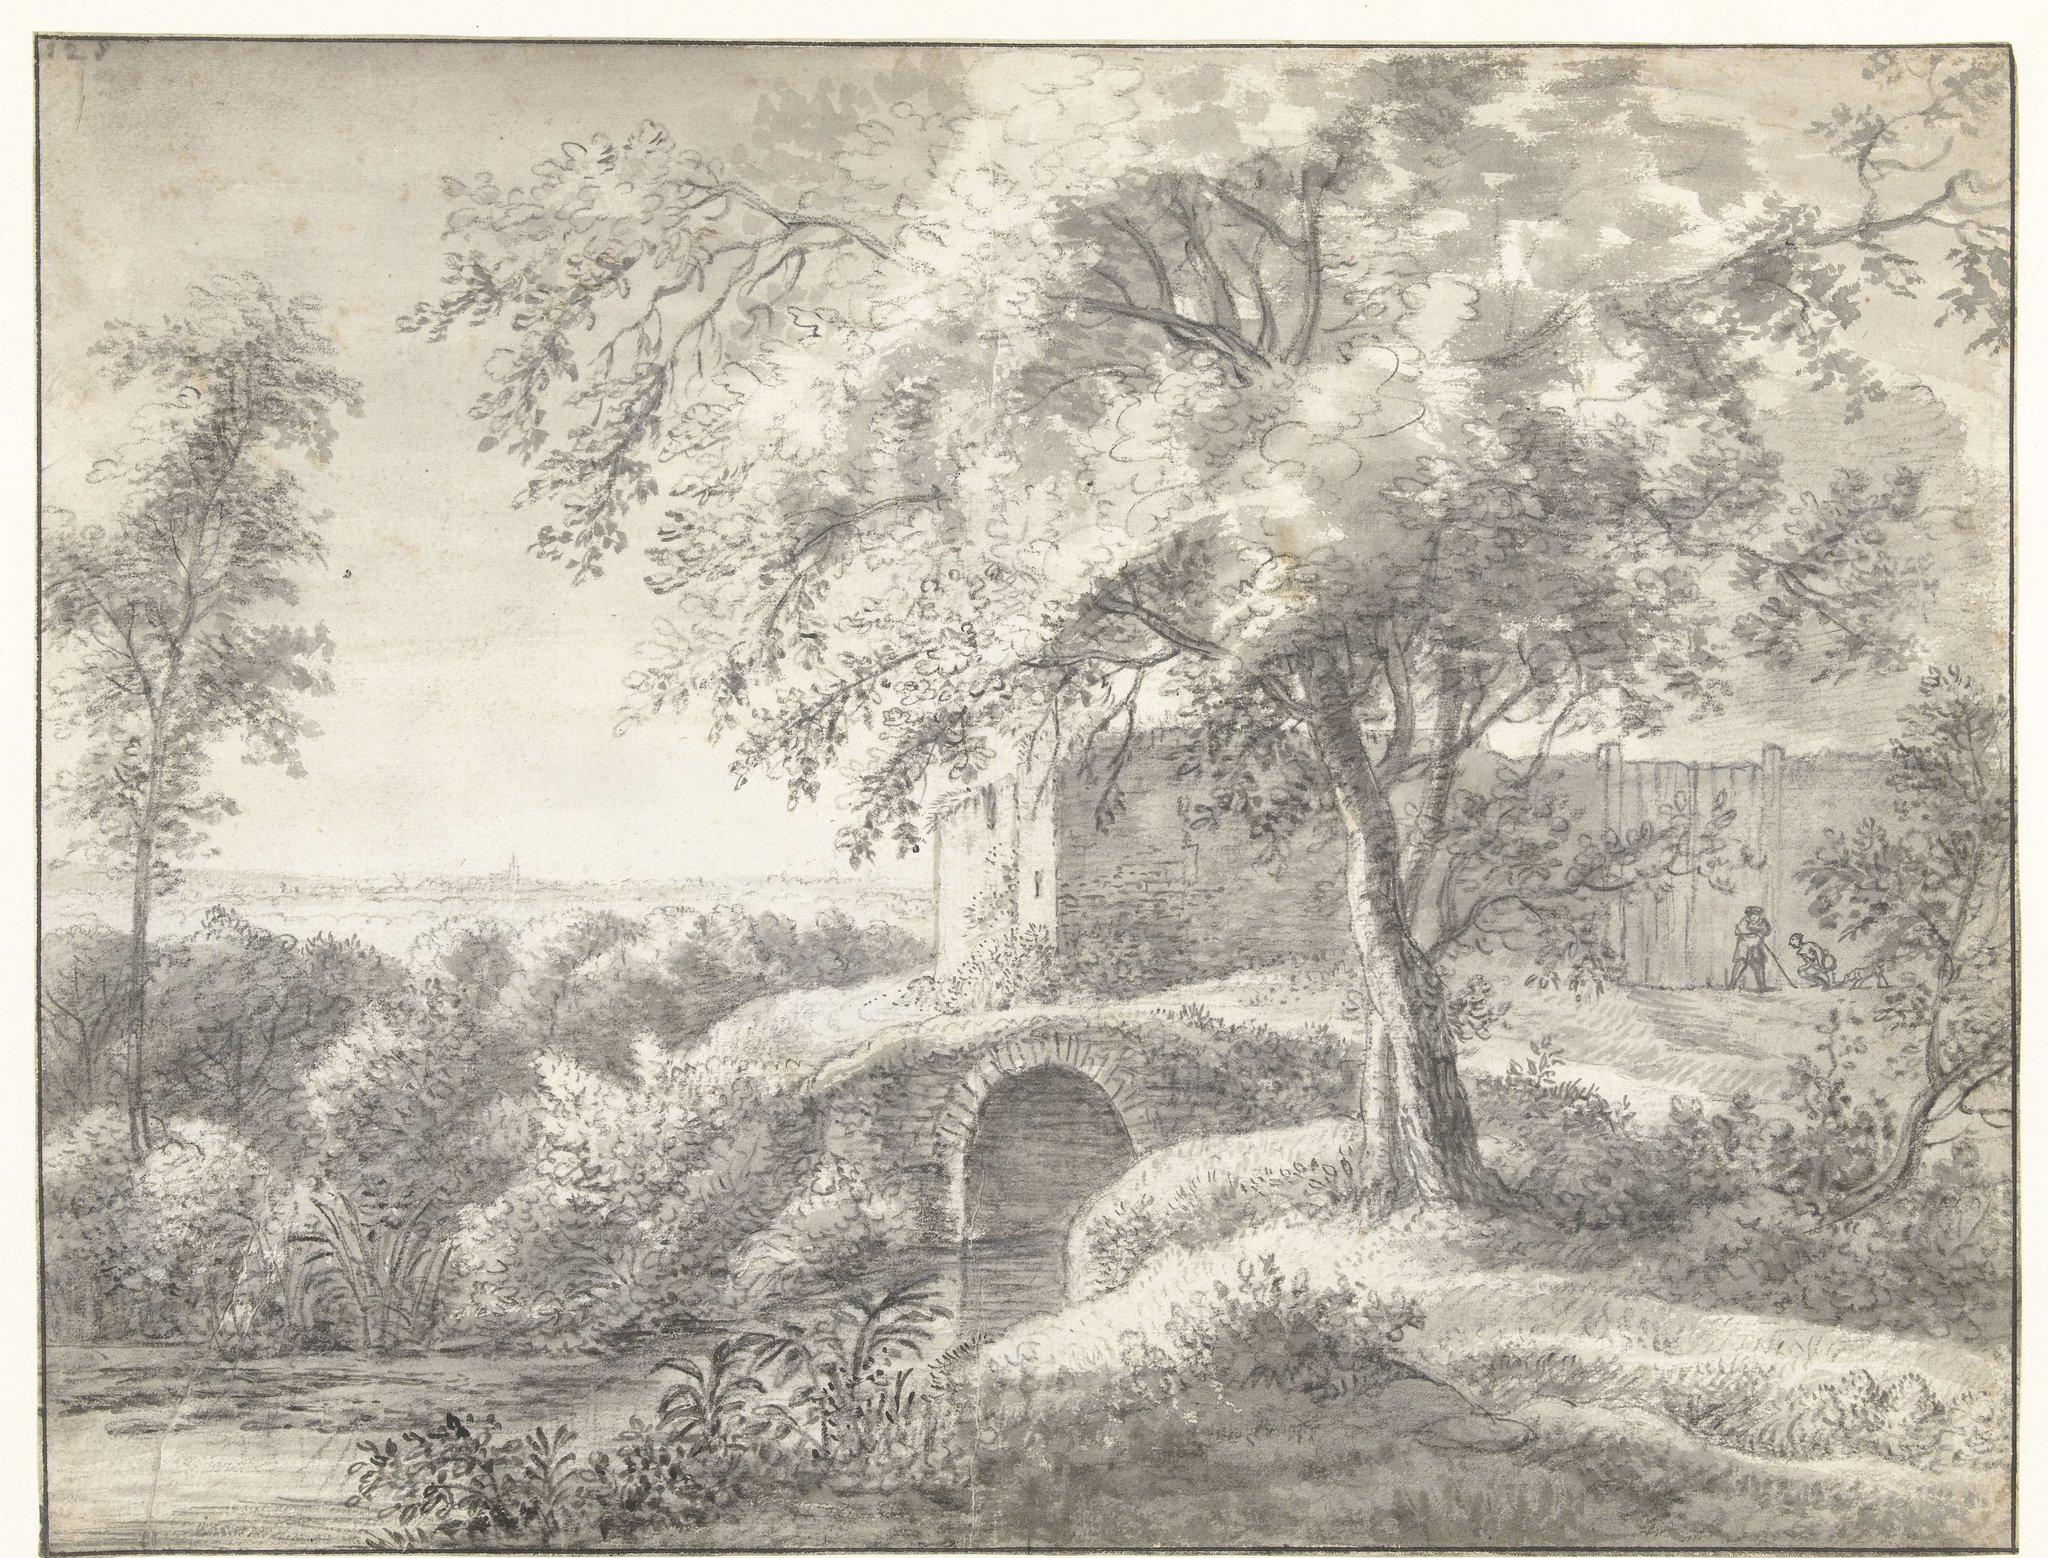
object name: drawing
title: Landschap met een stenen brug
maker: anthonie waterloo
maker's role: draughtsman, painter, print maker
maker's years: 1609-1690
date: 1619-1690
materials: chalk, paper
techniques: brush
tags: landscape with bridge, viaduct or aqueduct